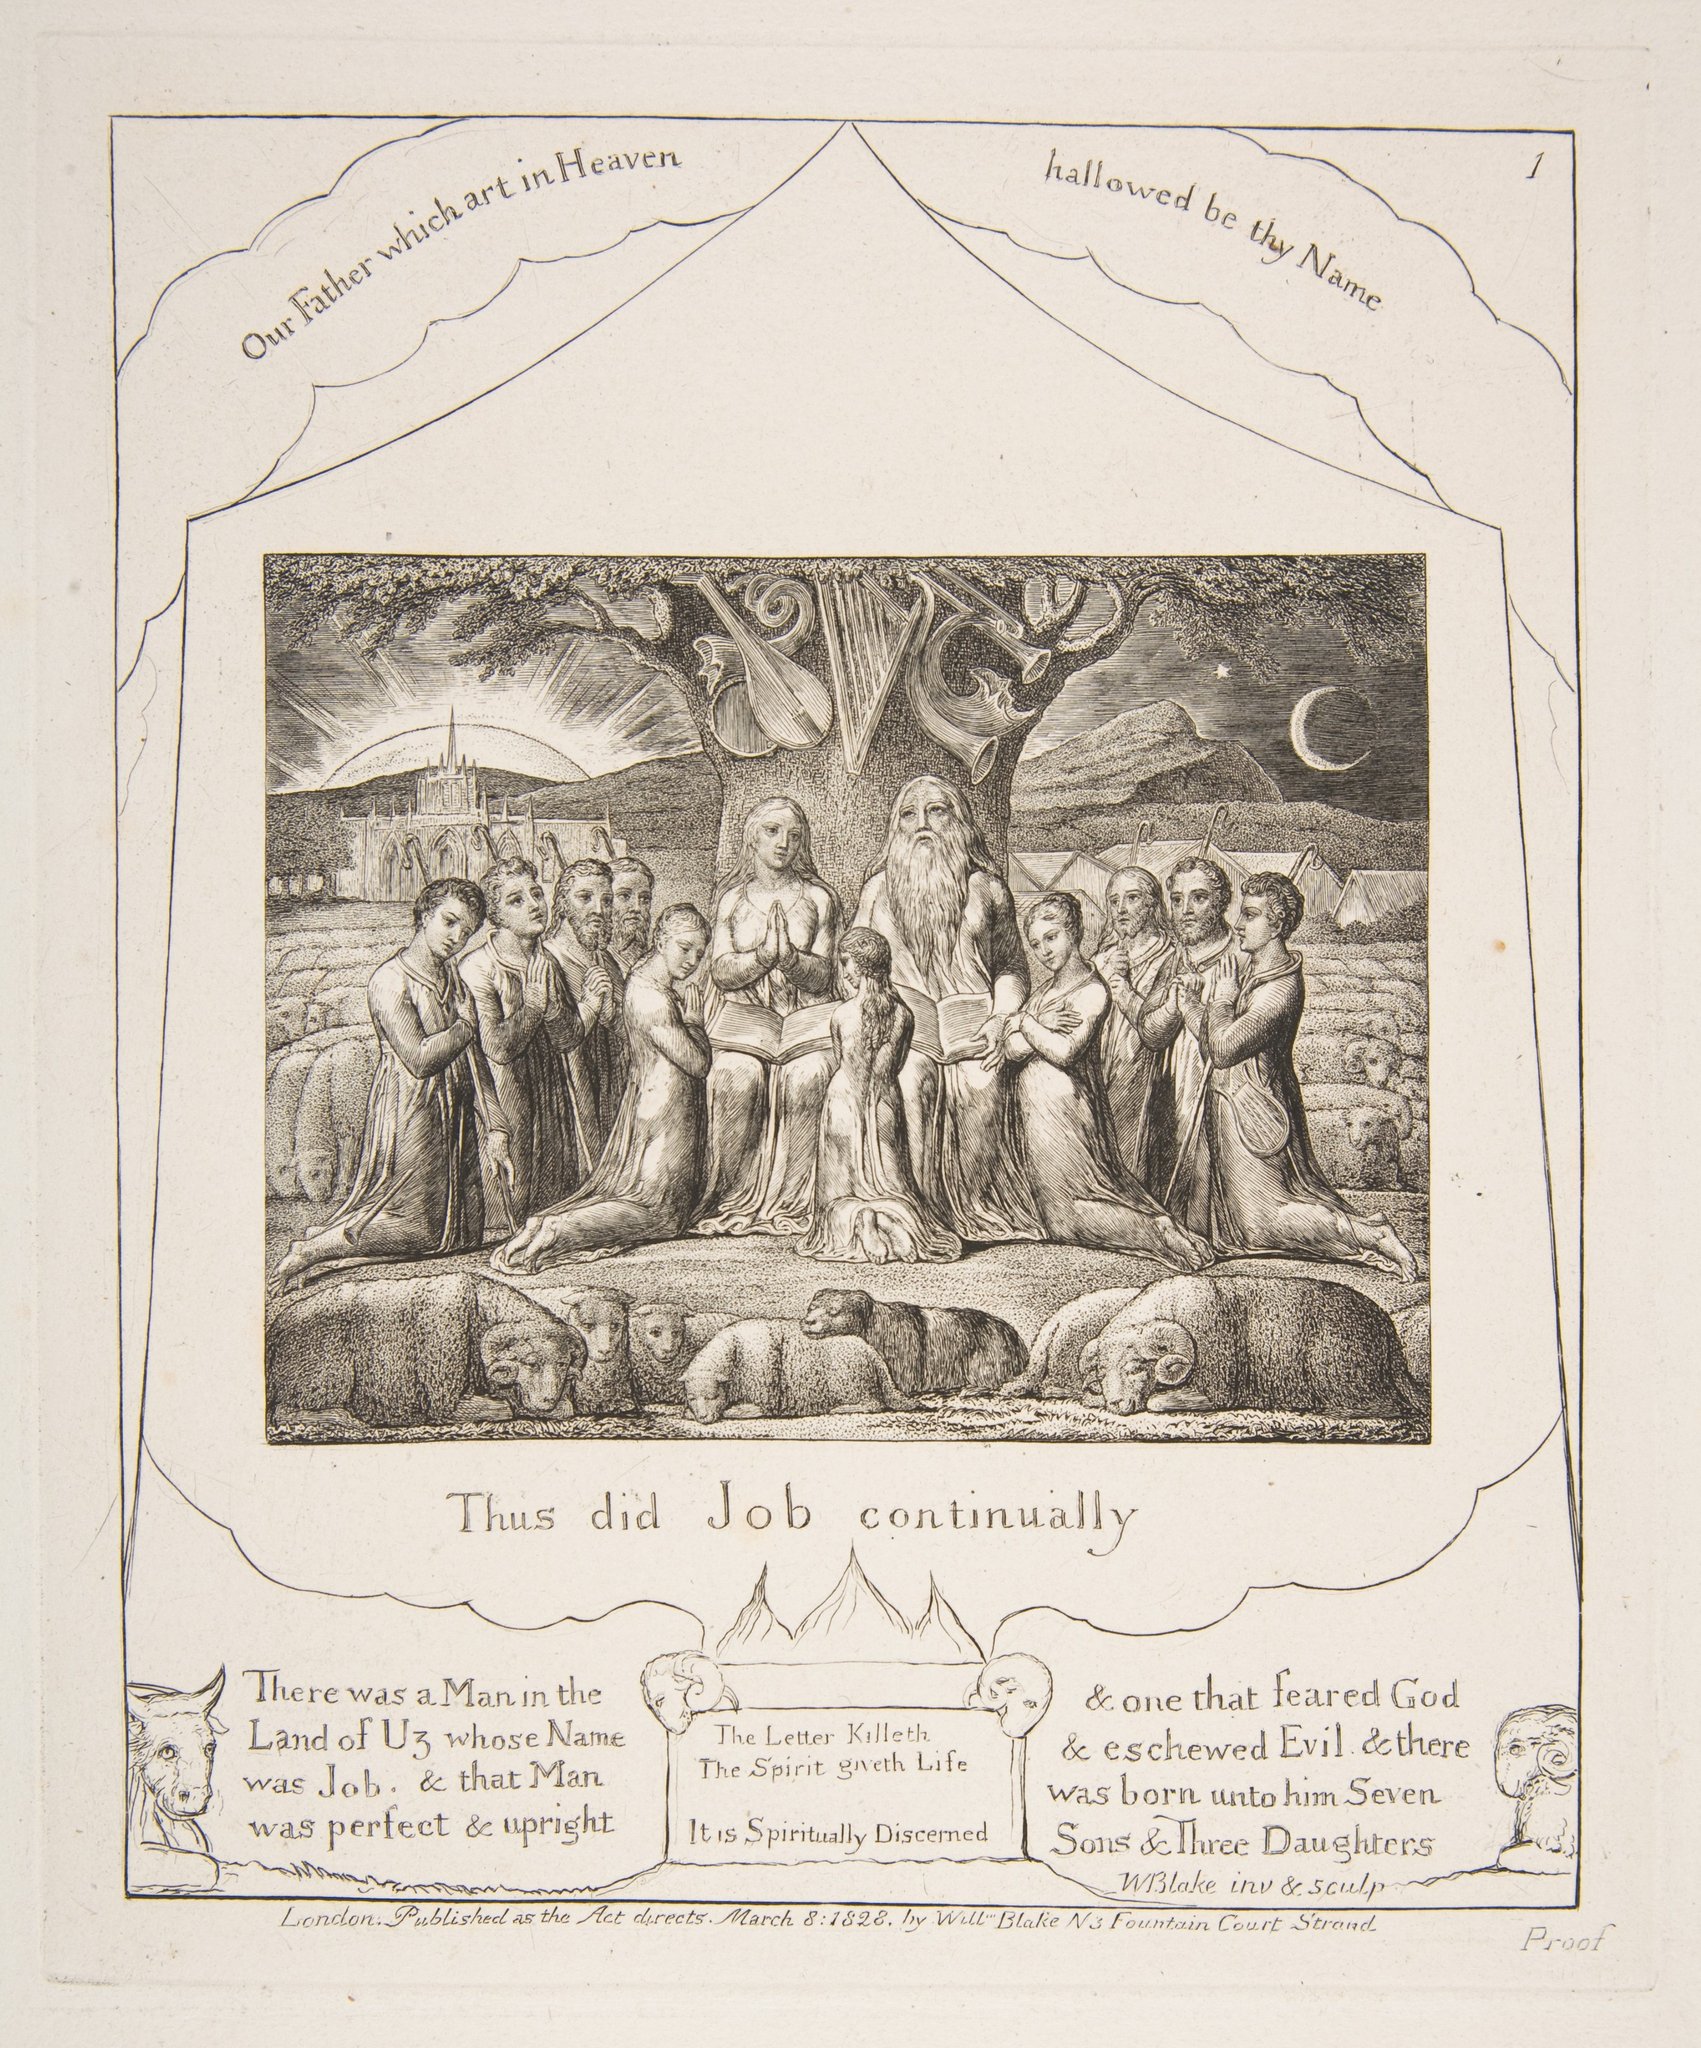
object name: print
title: Job and His Family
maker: william blake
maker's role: artist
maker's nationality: british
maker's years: 1757-1827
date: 1825-1826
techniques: engraving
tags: animals,men,women,sun